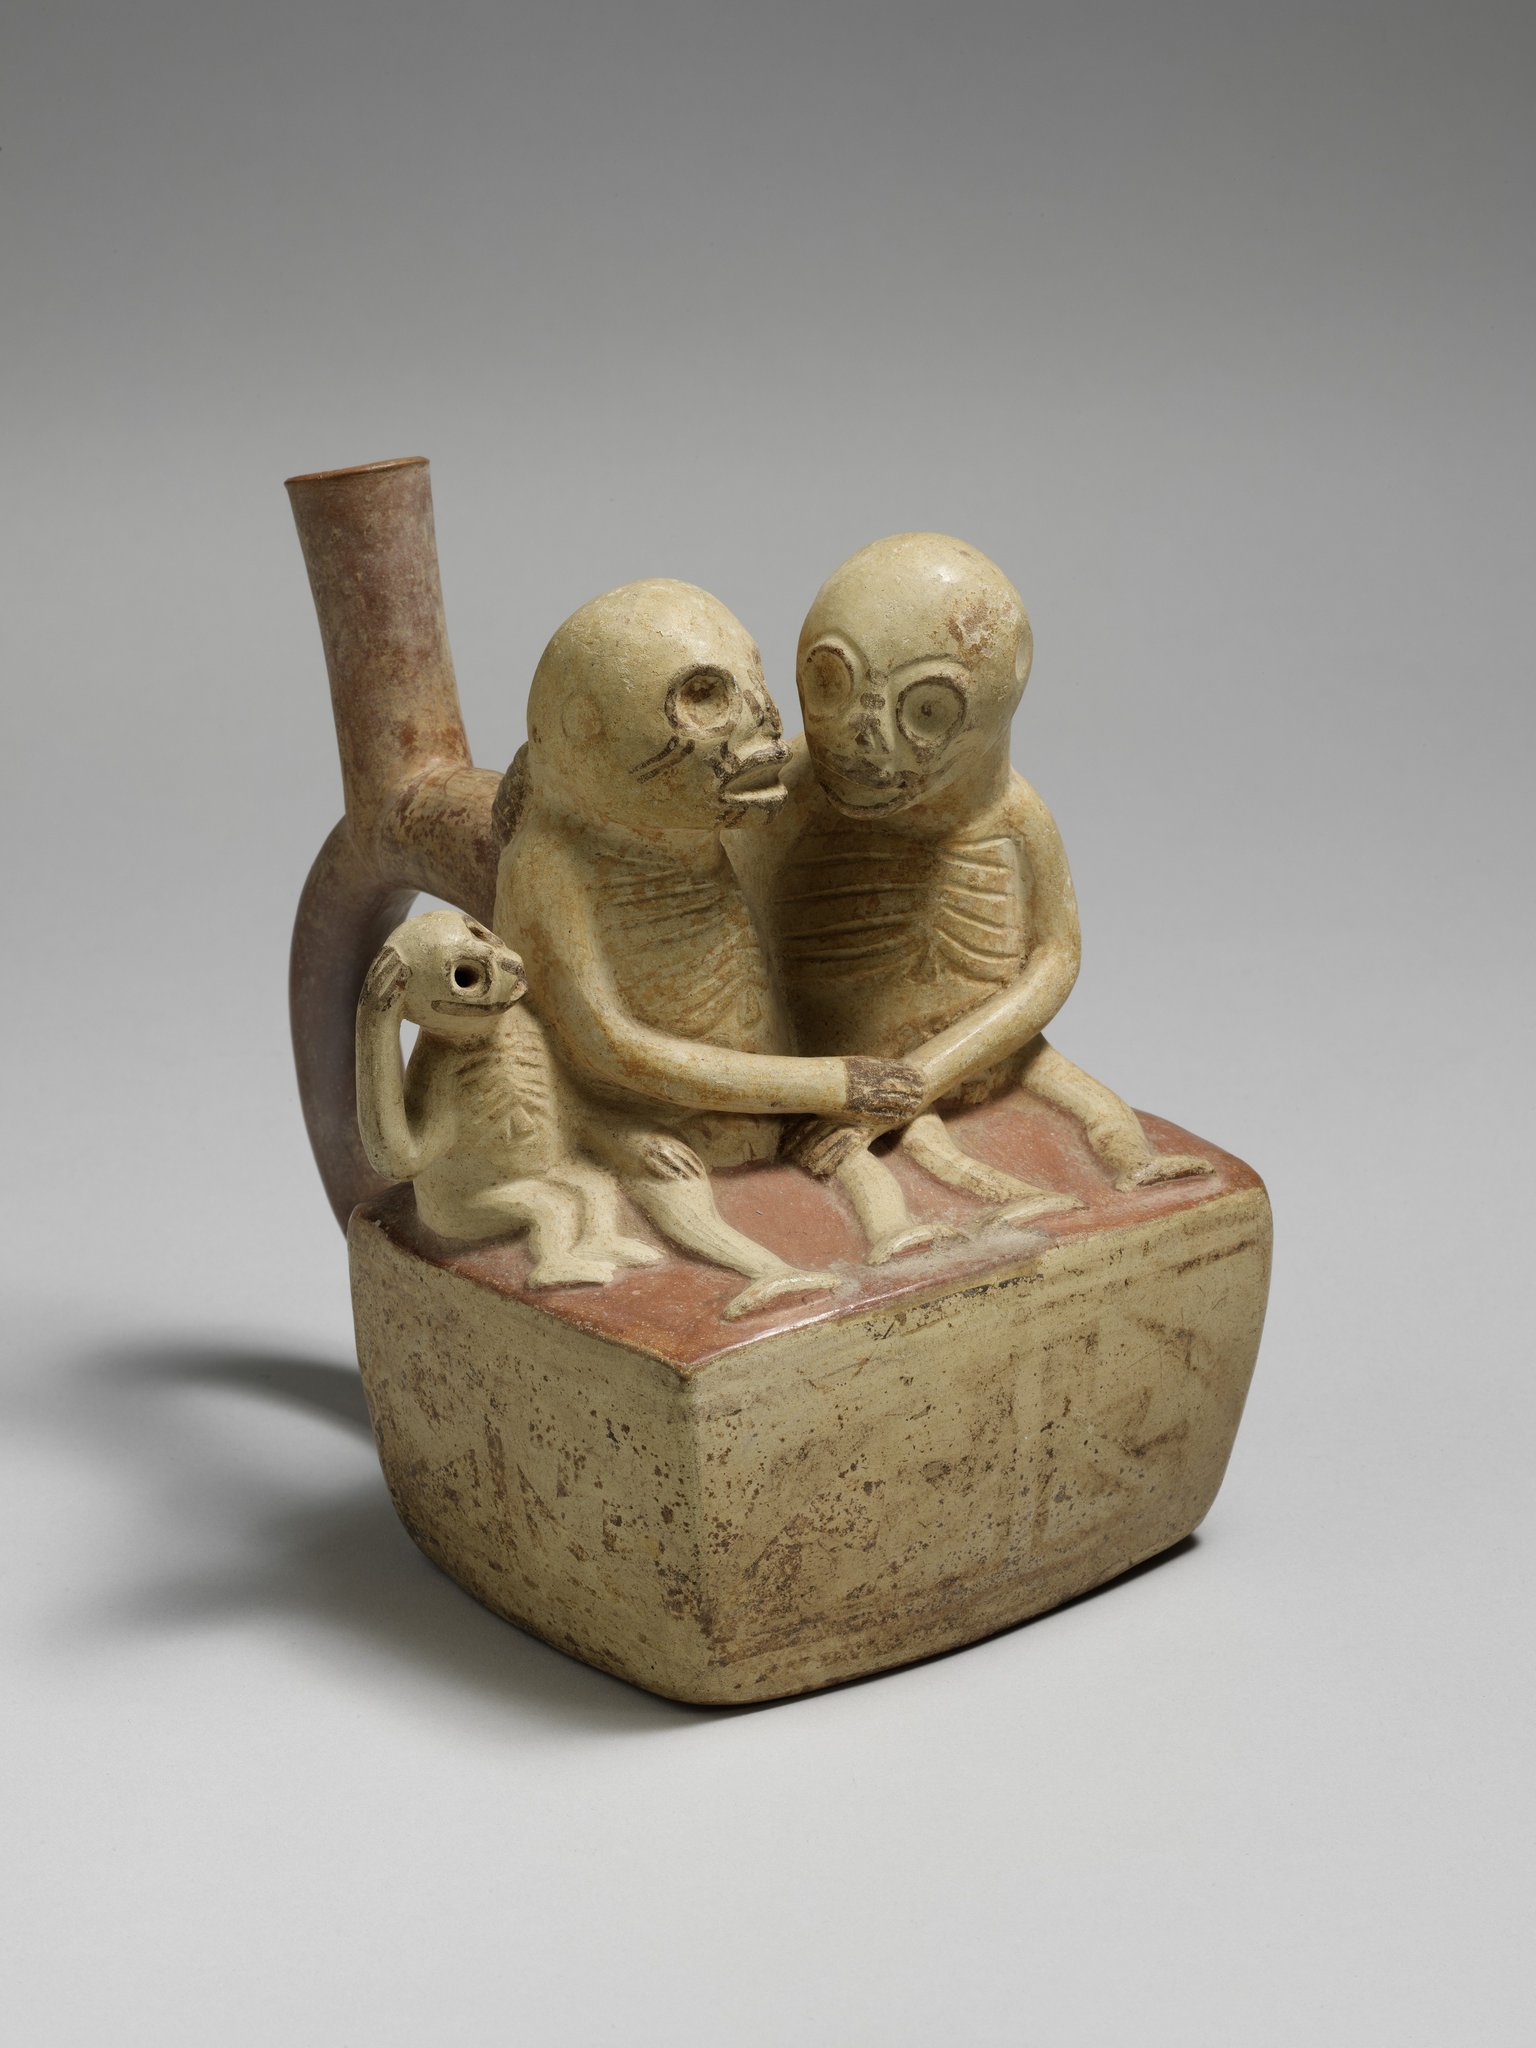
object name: bottle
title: Bottle, Skeletal Couple with Child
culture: moche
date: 201-700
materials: ceramic, pigment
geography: peru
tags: skeletons,children,couples